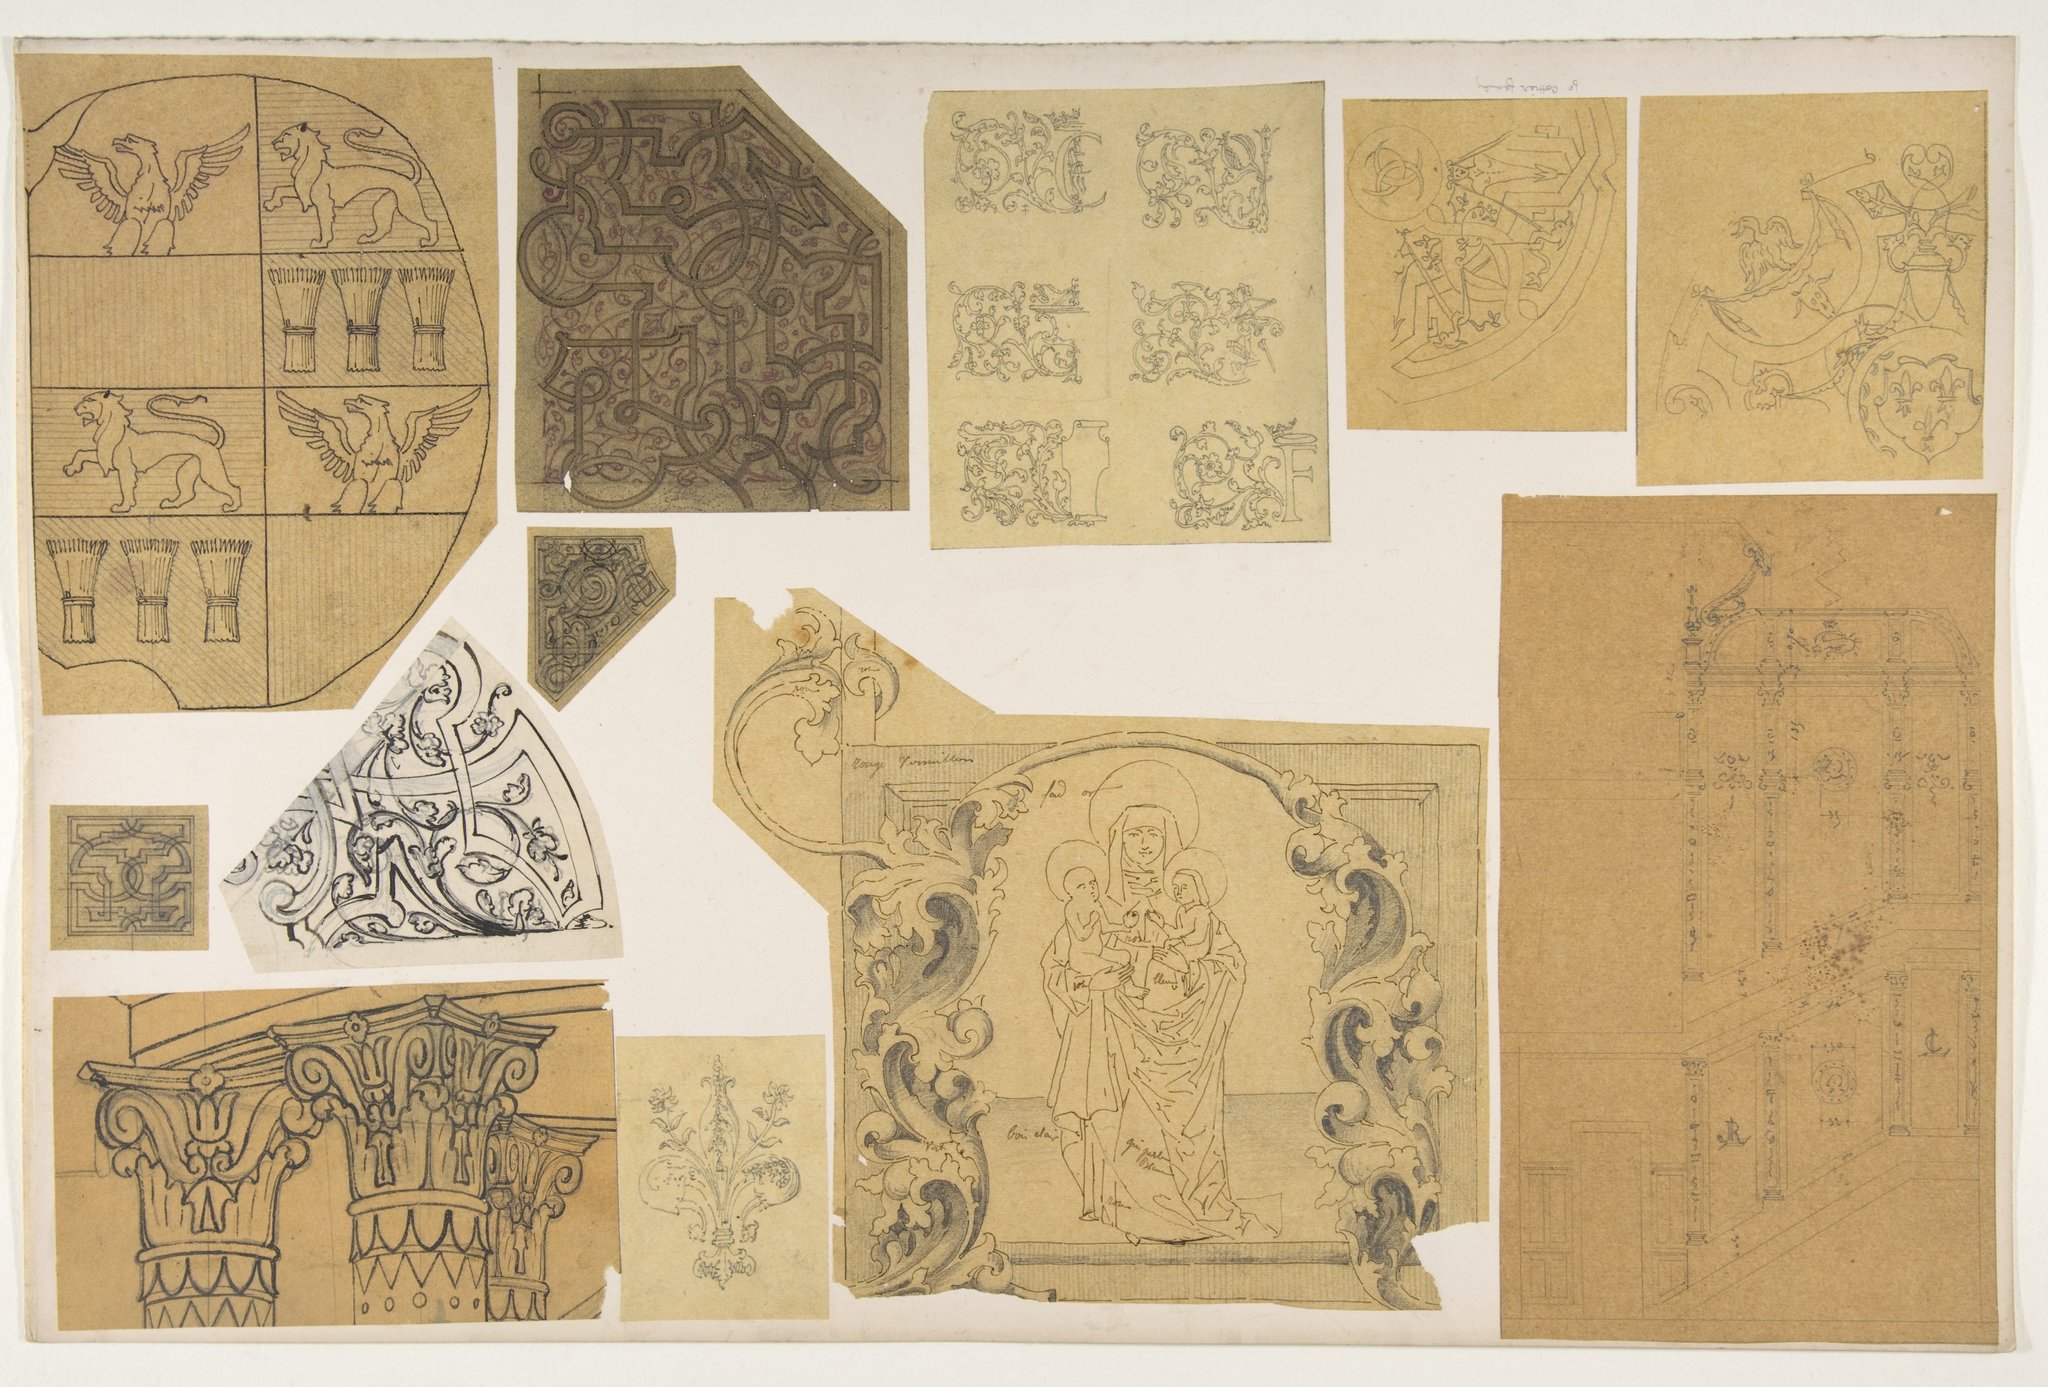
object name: drawing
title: Twelve ornamental designs for the decoration of interiors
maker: jules-edmond-charles lachaise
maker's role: artist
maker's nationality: french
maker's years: 1897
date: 1851-1900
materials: graphite, ink, paper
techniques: pen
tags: ornament